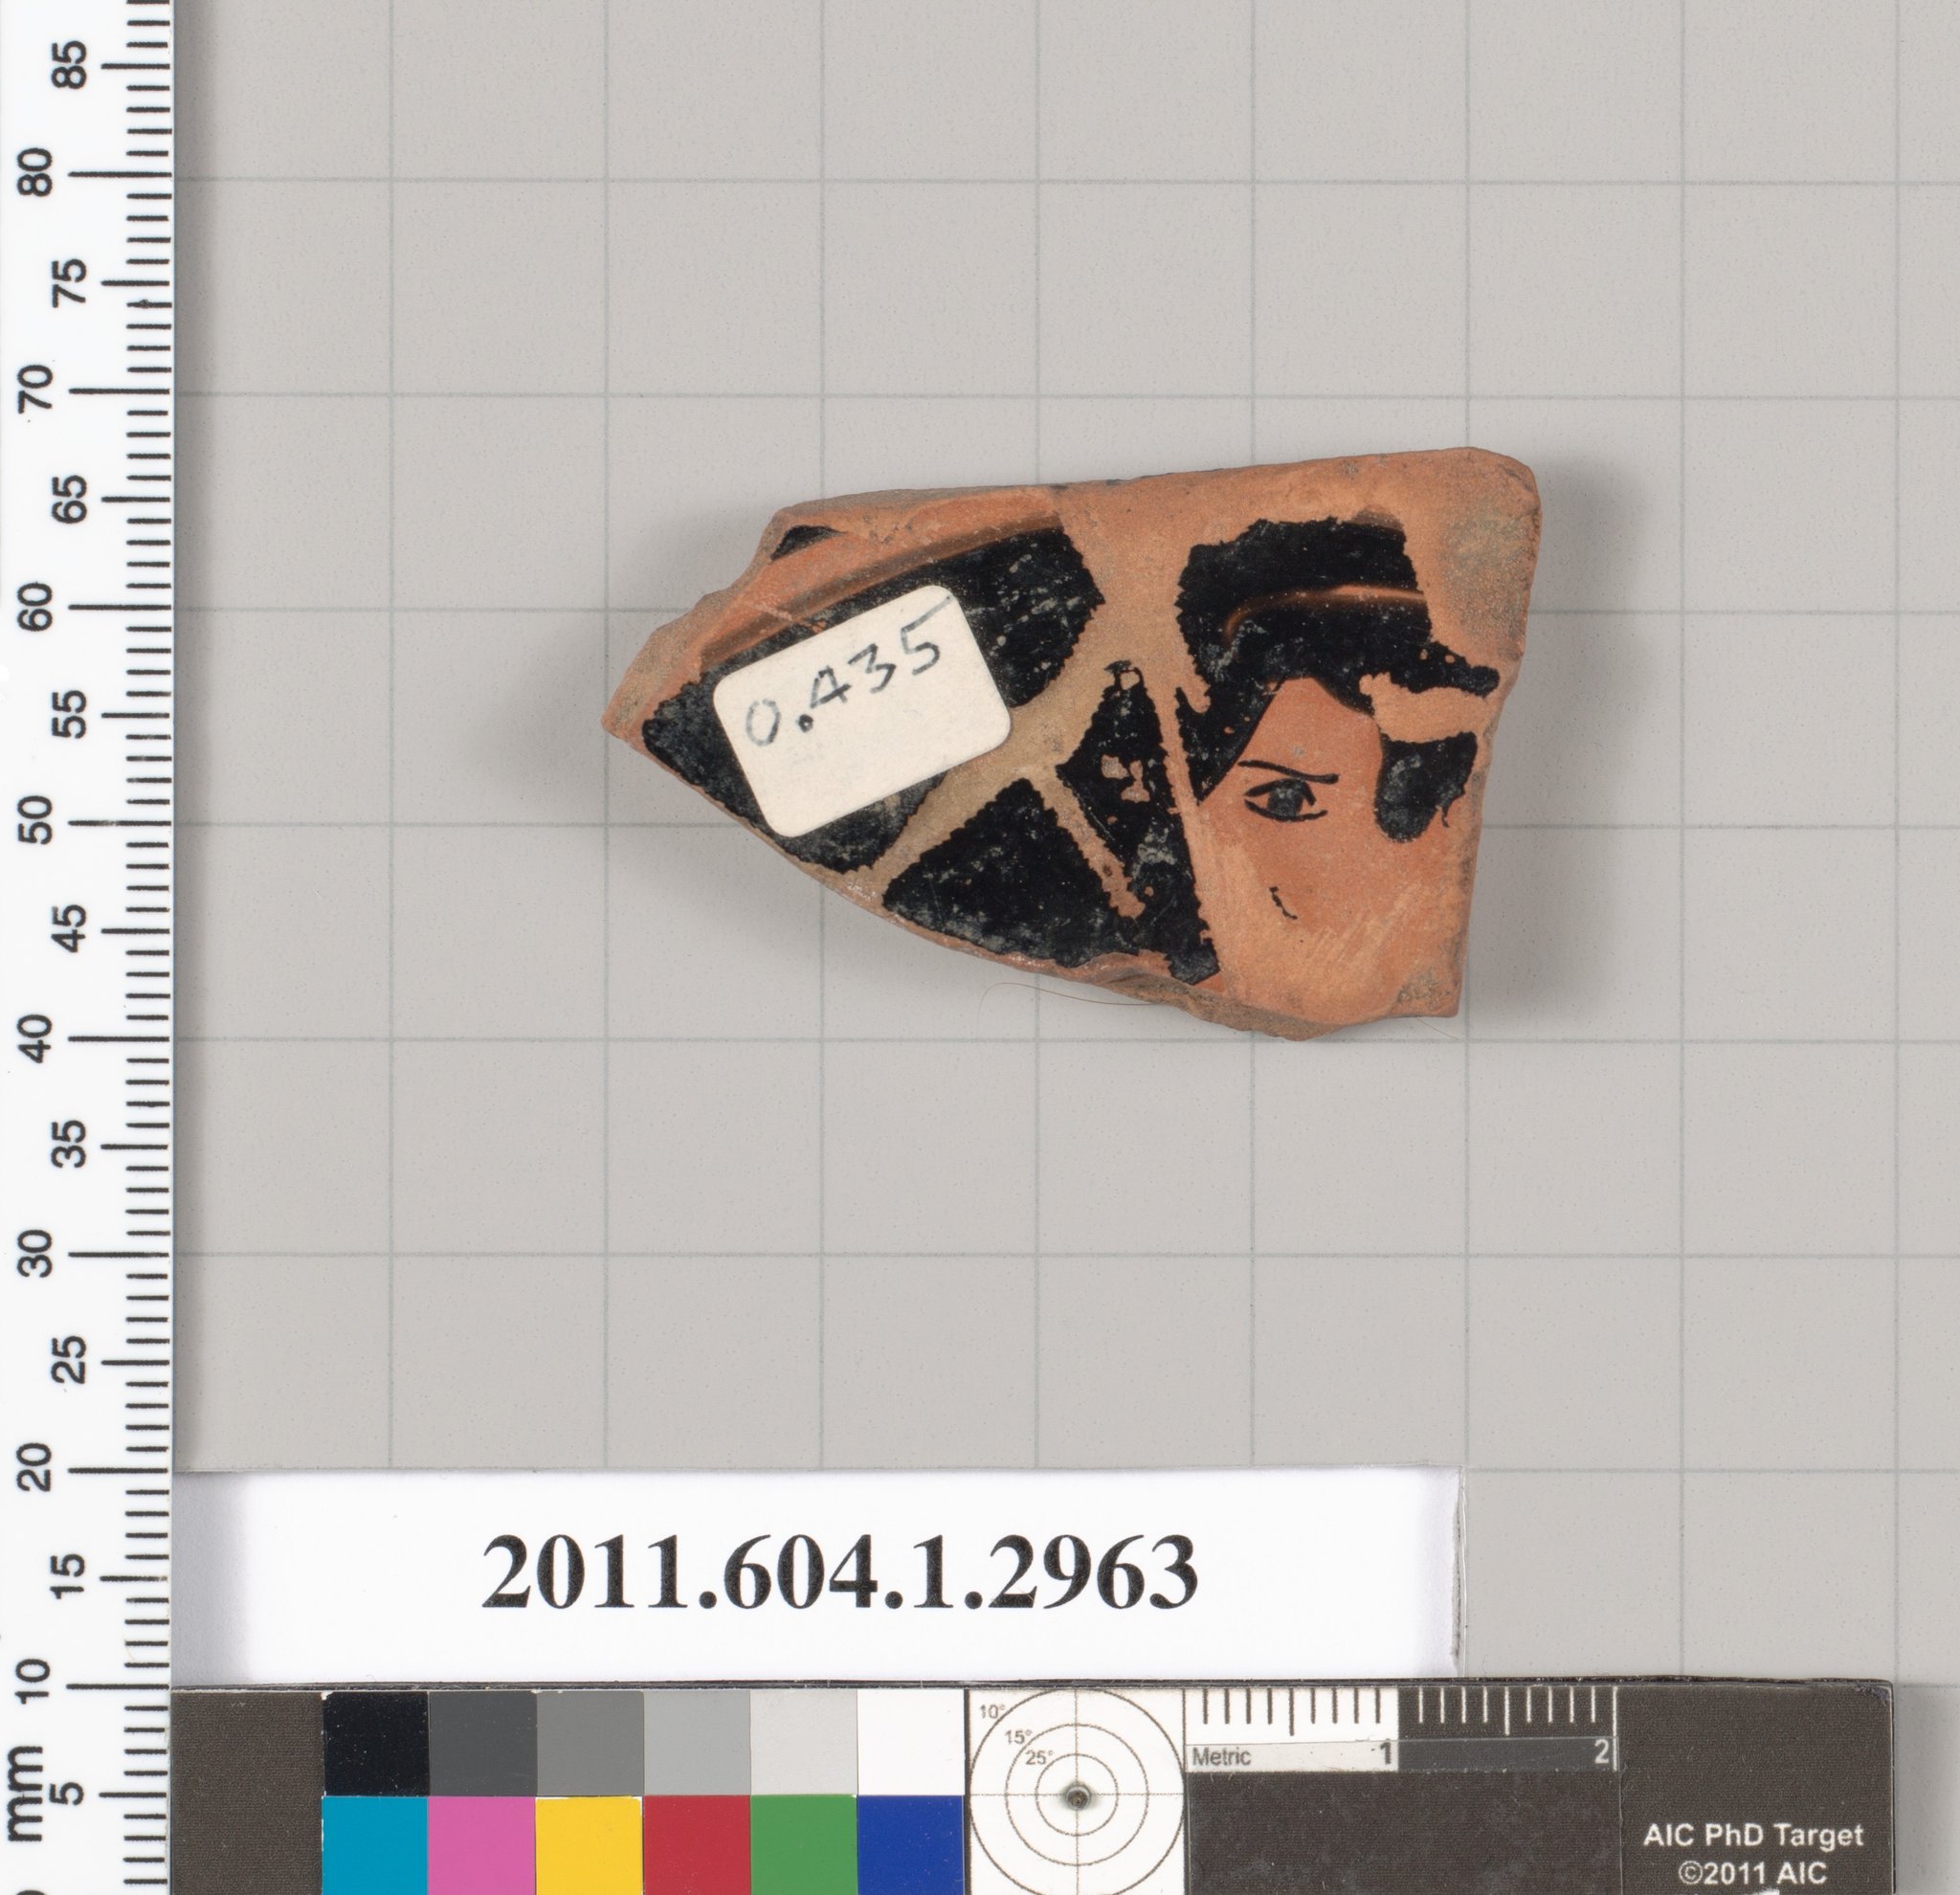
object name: kylix fragment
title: Terracotta fragment of a kylix (drinking cup)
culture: greek, attic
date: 520-500 BCE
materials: terracotta